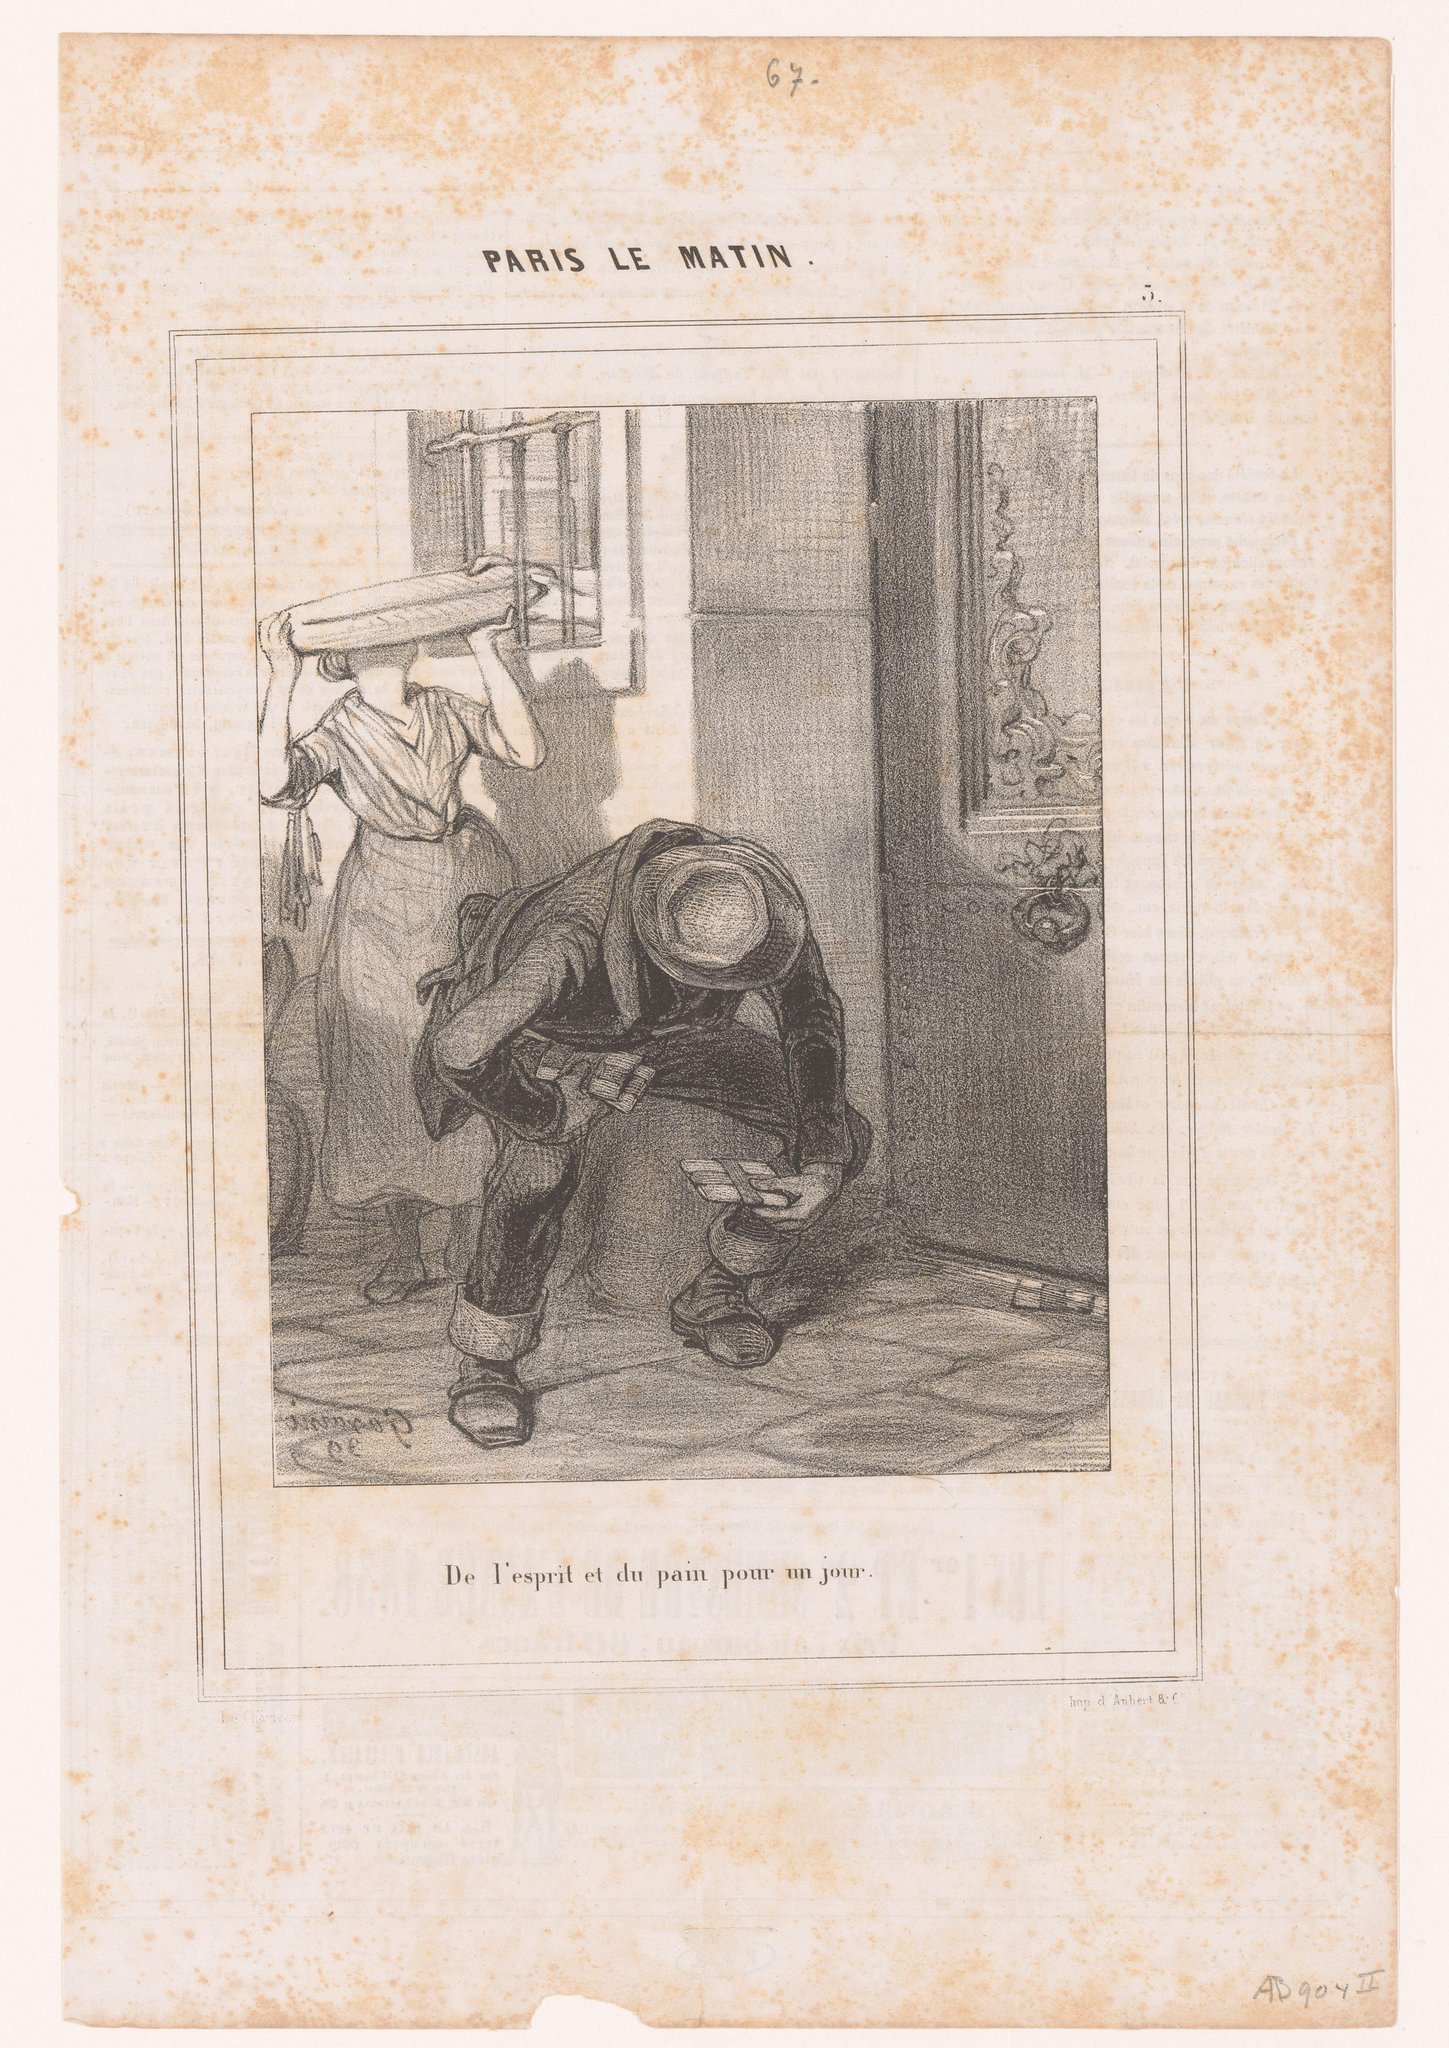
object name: print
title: De l'esprit et du pain pour un jour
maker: paul gavarni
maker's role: draughtsman, print maker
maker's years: 1804-1866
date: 1839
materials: paper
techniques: lithograph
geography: paris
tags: delivering; receiving (~ postal matter), bread, loaf, baker, postman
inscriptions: collector's mark: Lugt 2228a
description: Prent gebruikt voor: Le Charivari, 19 maart 1839.